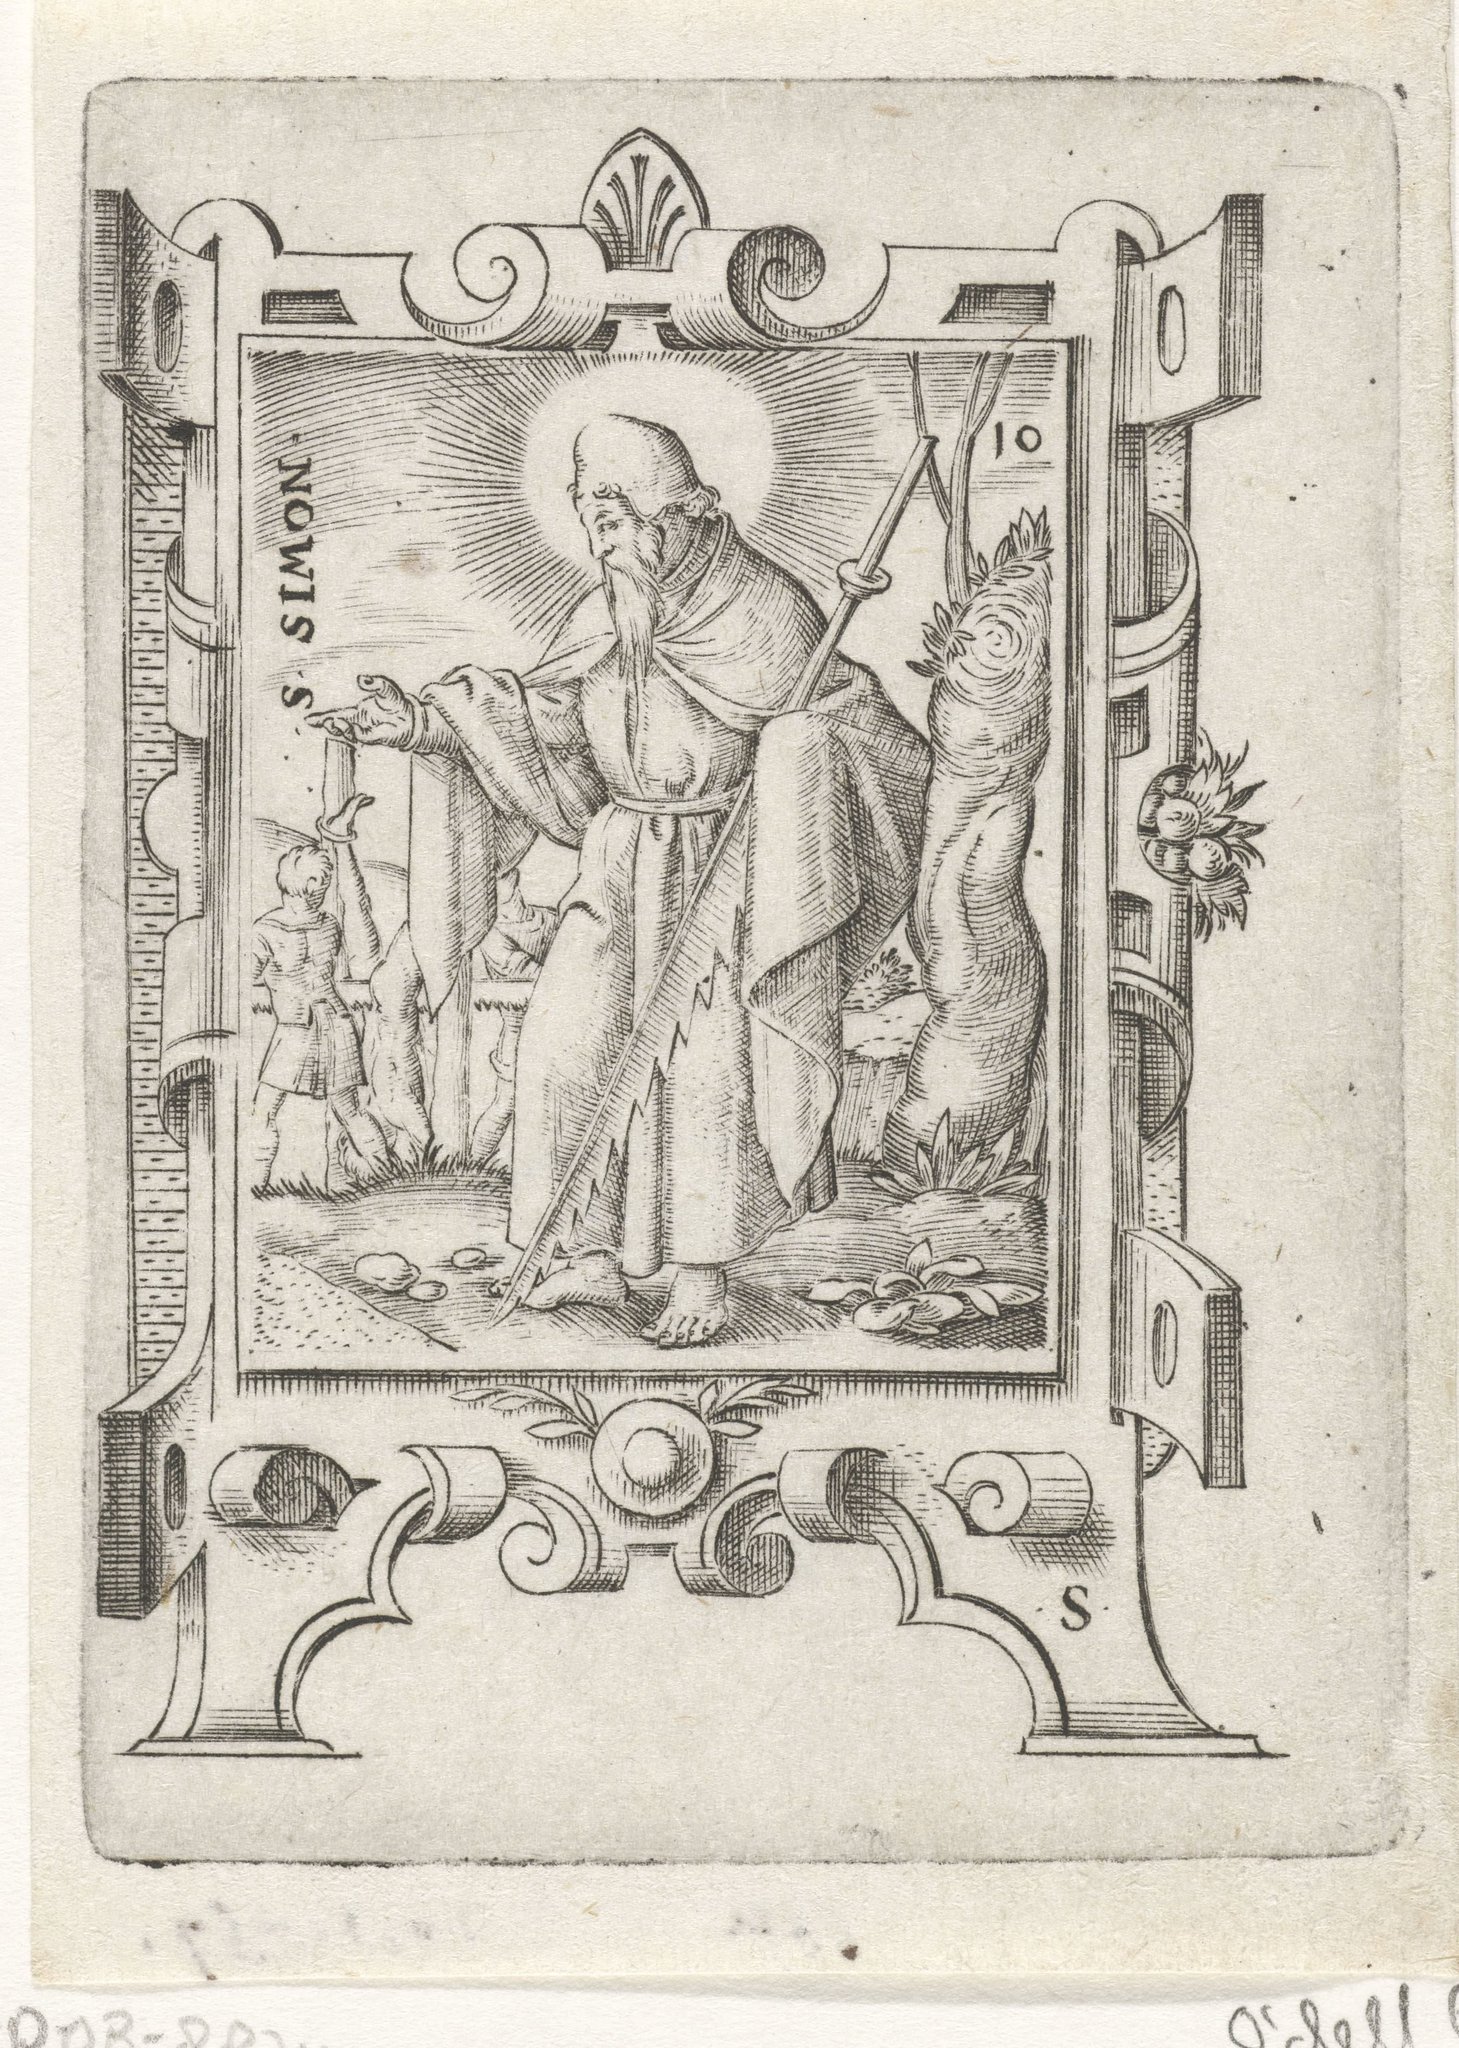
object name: print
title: H. Simon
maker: virgilius solis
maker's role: draughtsman, print maker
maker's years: 1514-1562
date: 1524-1562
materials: paper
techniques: engraving